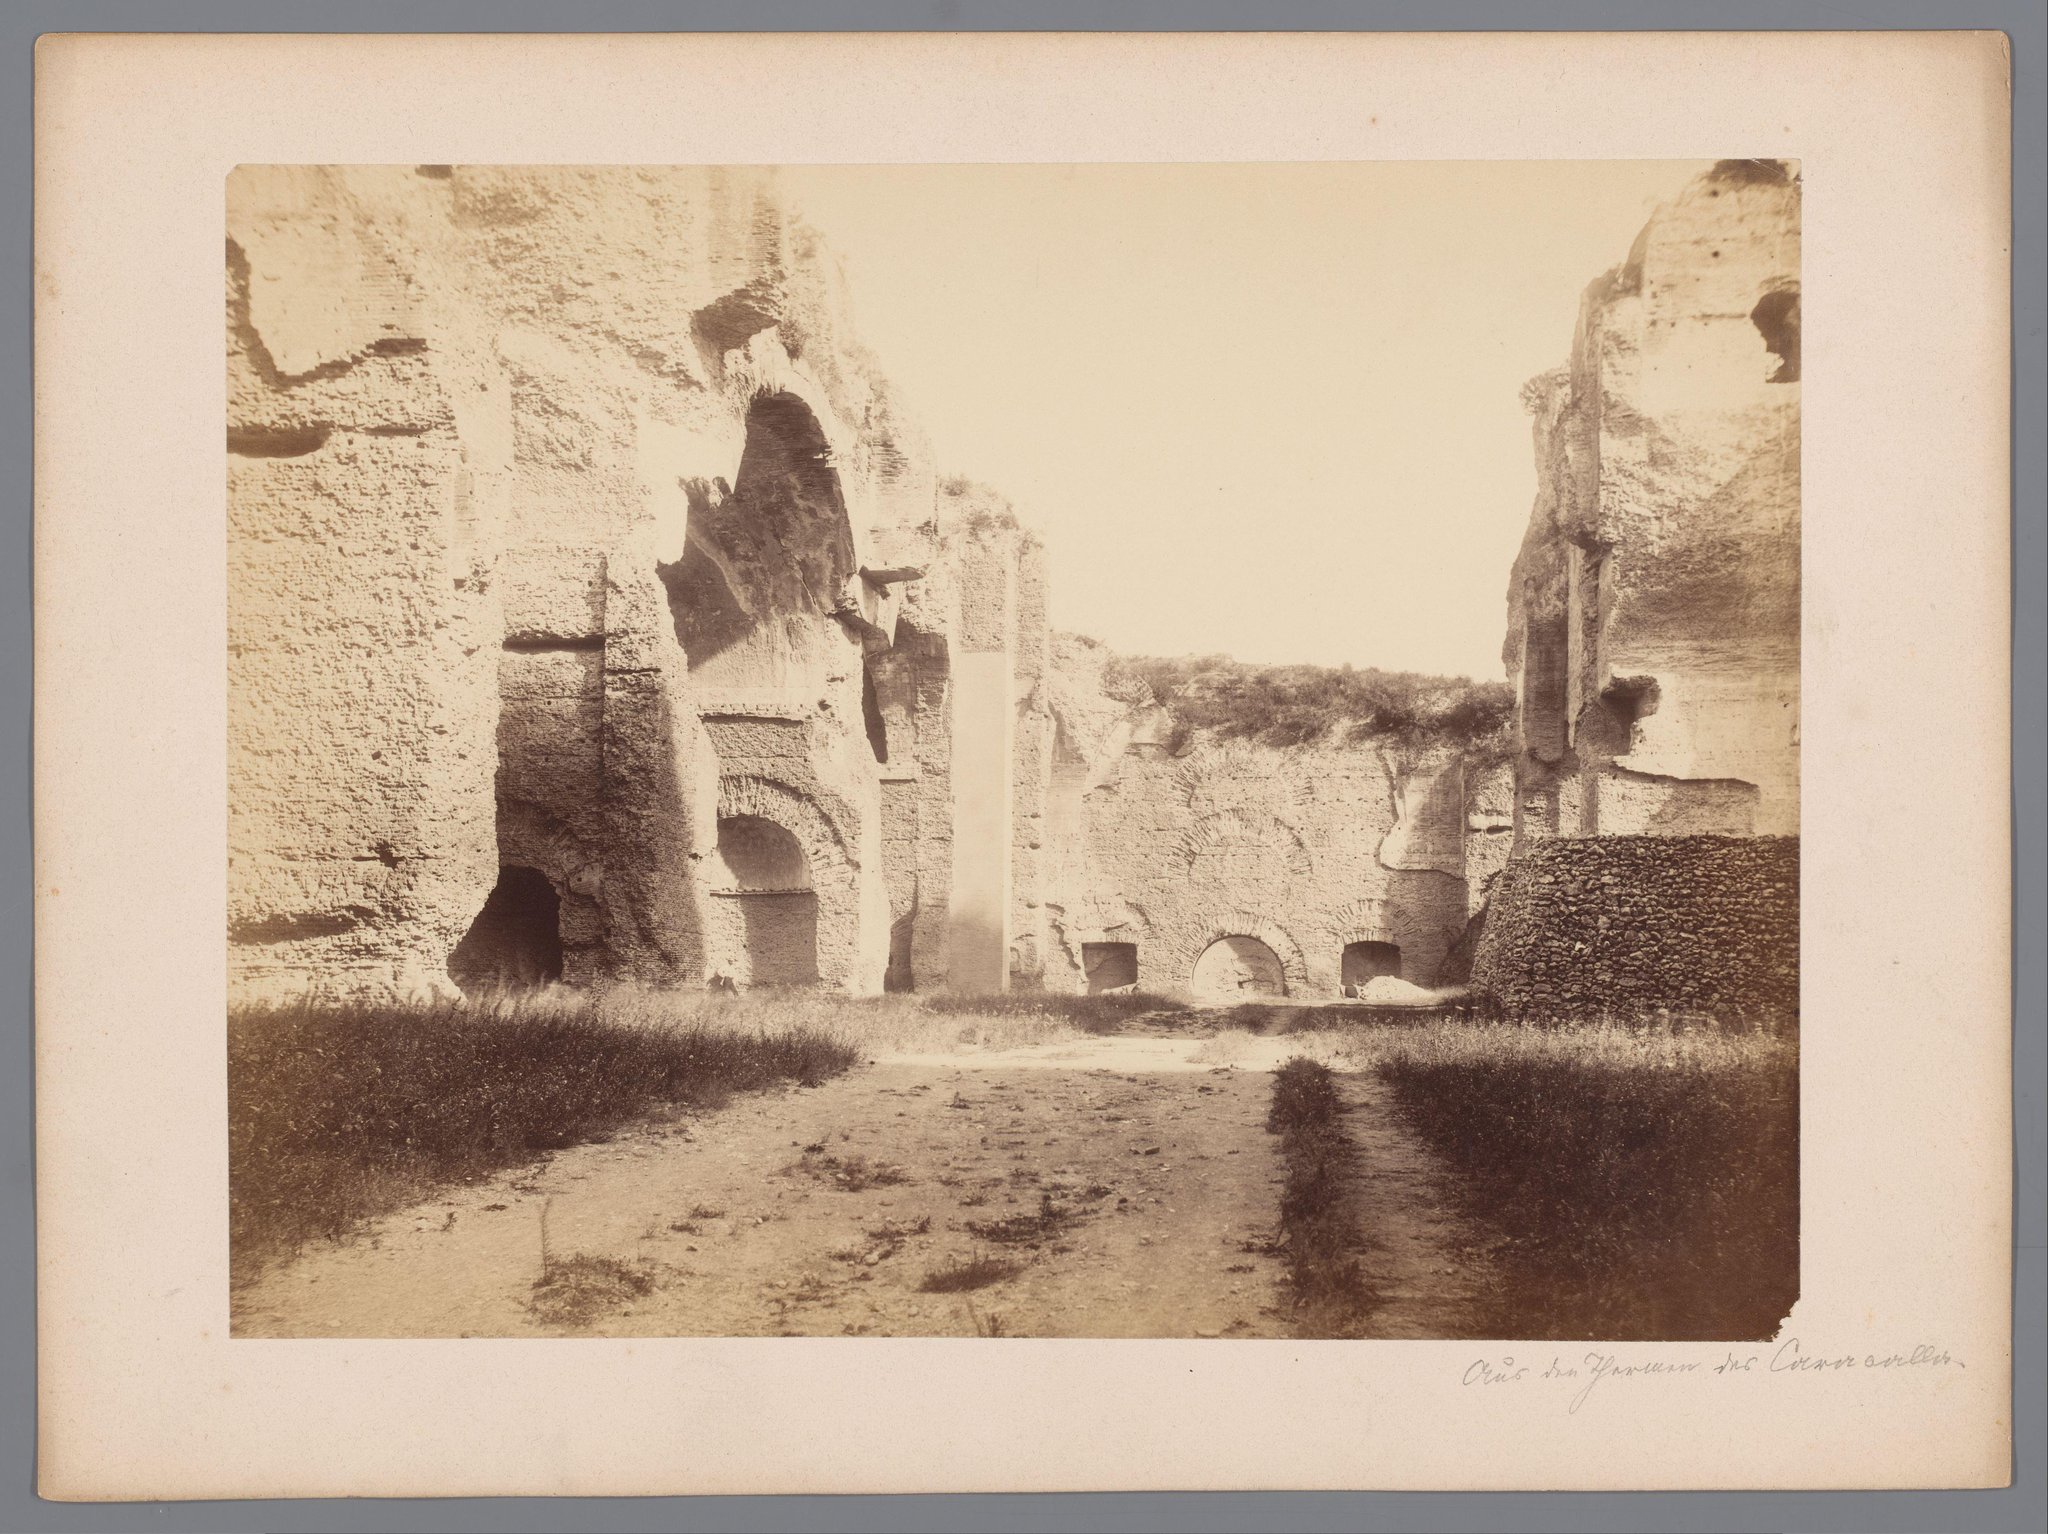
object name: photograph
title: Thermen van Caracalla te Rome, Italië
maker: Anonymous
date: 1851-1900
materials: cardboard, paper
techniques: albumen print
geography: rome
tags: ruin of a building ~ architecture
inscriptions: inscription: ‘[...]’